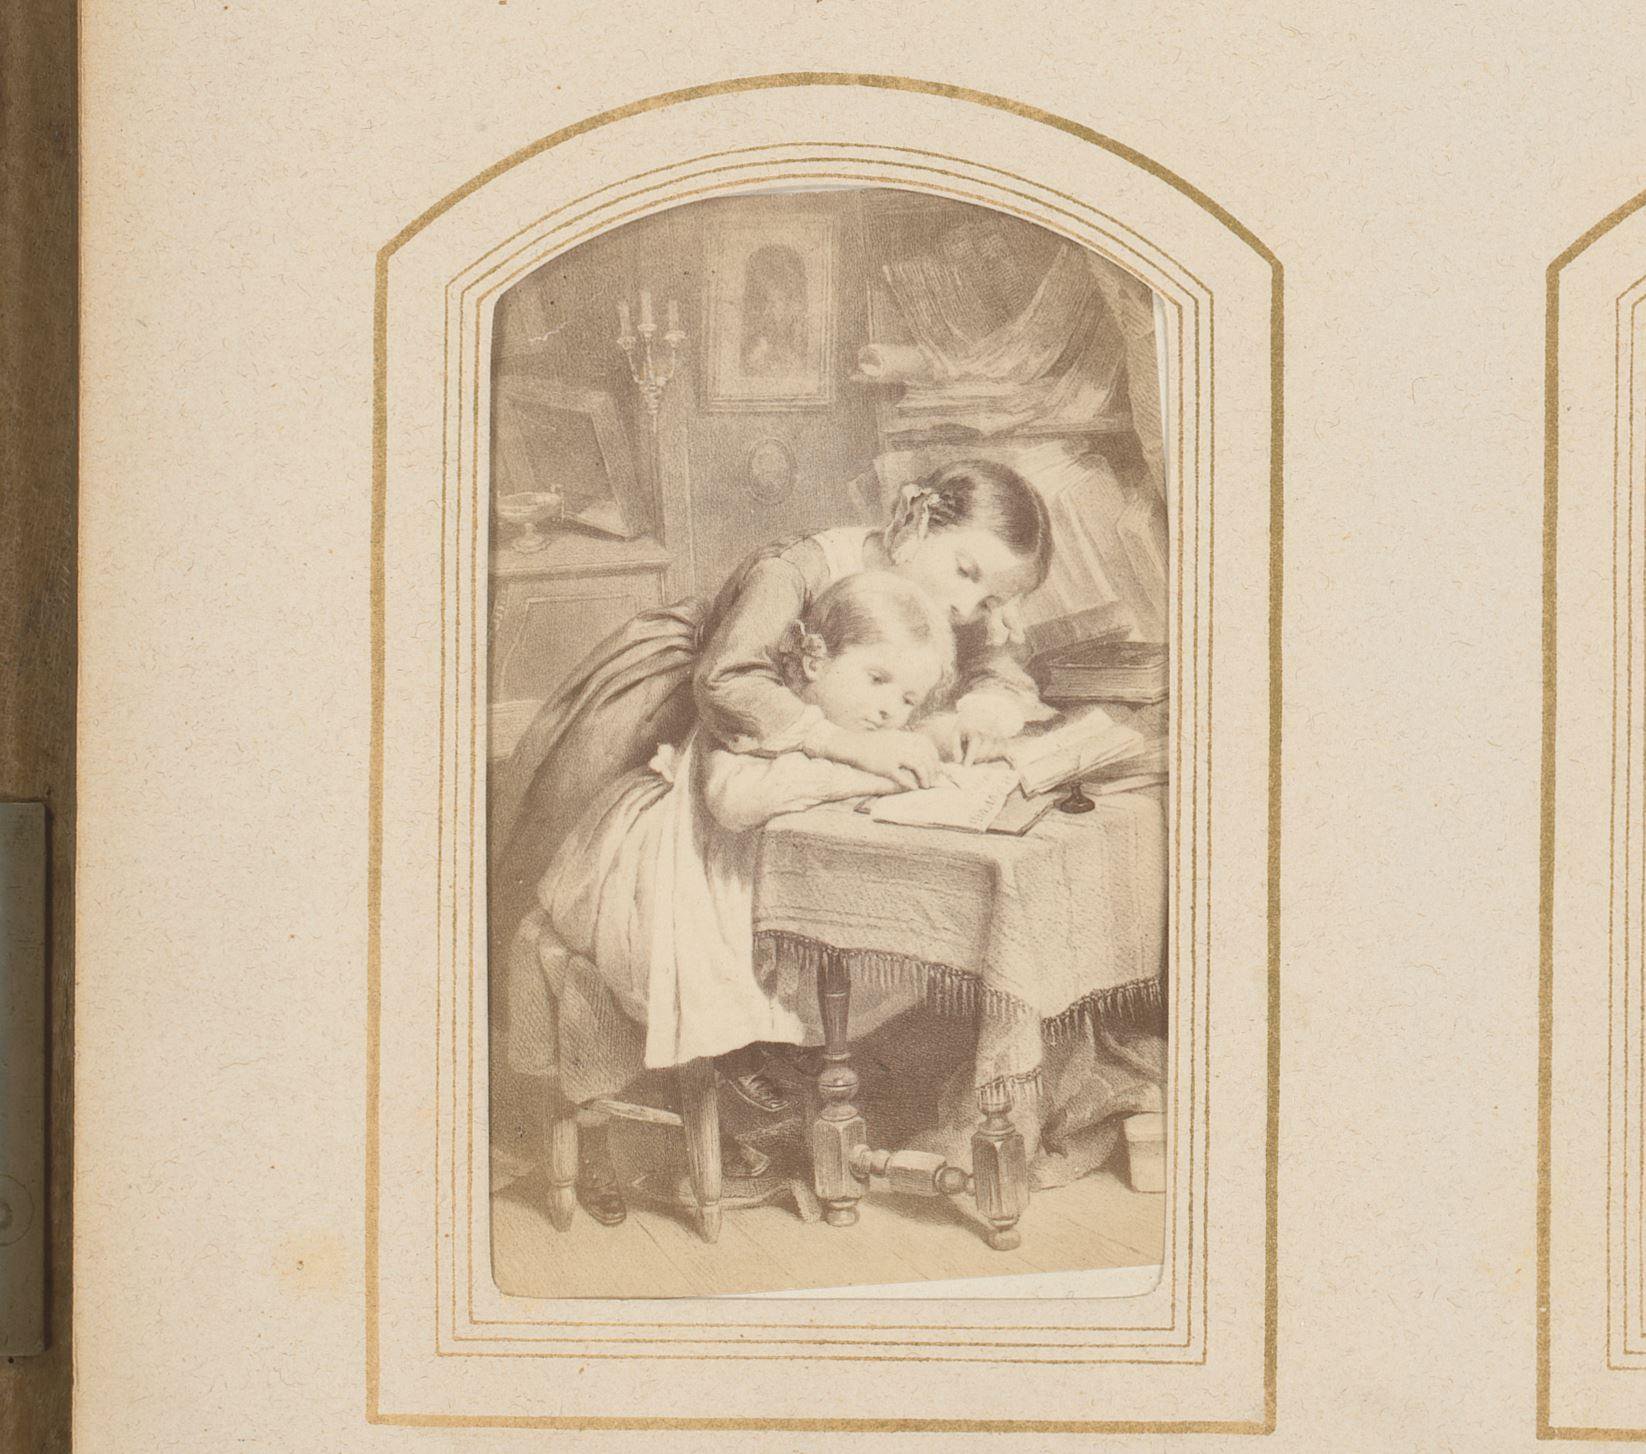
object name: album leaf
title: Fotoreproductie van La leçon d'écriture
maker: Anonymous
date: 1870-1900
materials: cardboard, photographic support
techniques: albumen print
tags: writing and letters, painting, drawing and the graphic arts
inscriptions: annotation: ‘der Schreibunterricht’, inscription: ‘Lanfant e Metz/ 1029/ La leçon d'écriture/ (...)’